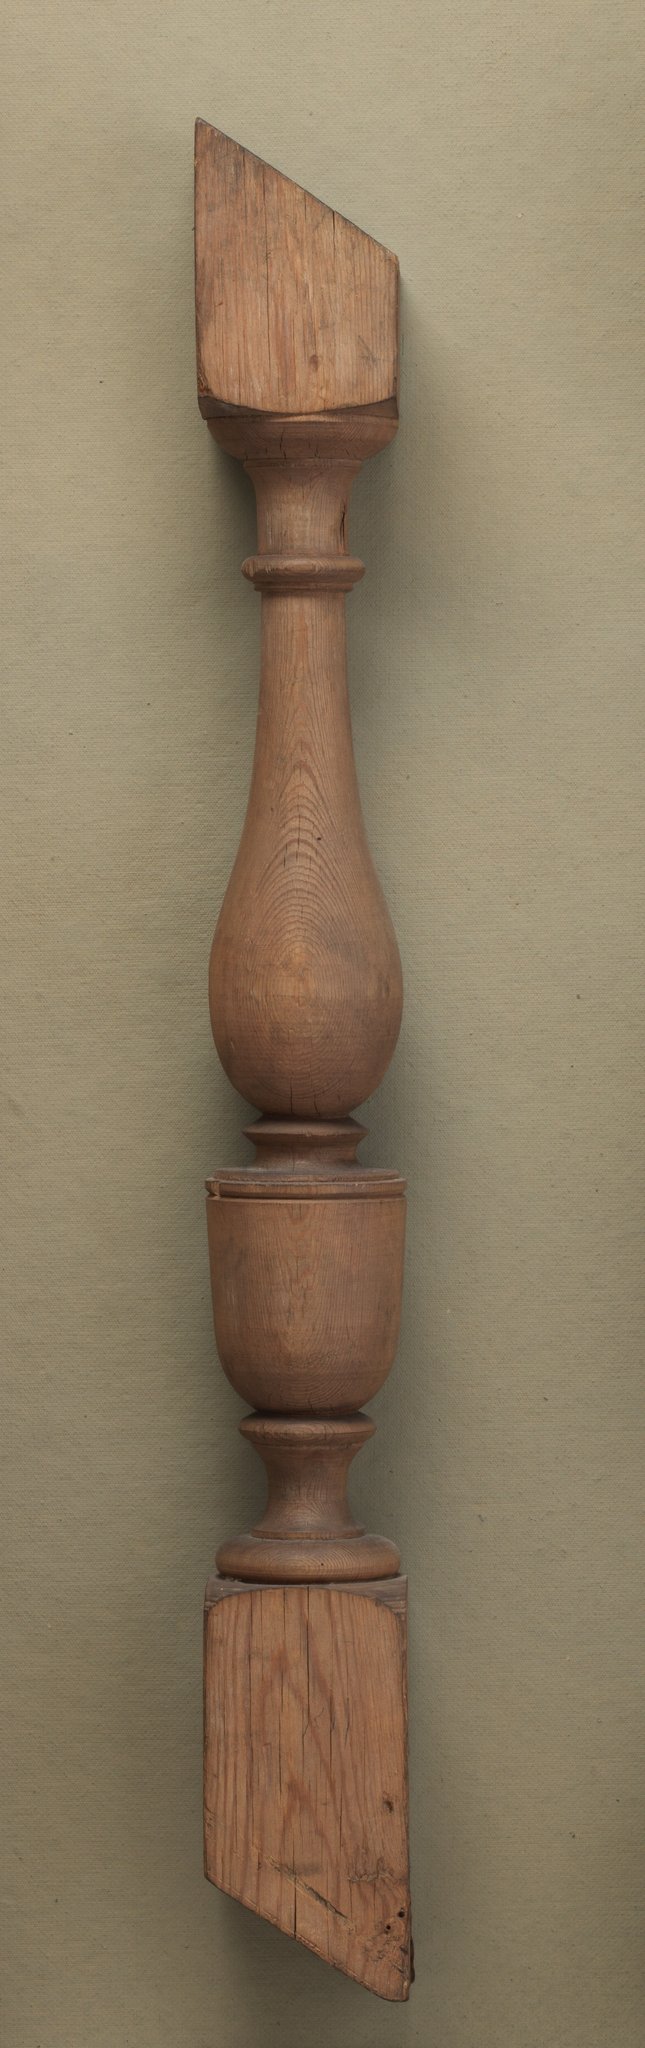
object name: baluster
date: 1667-1733